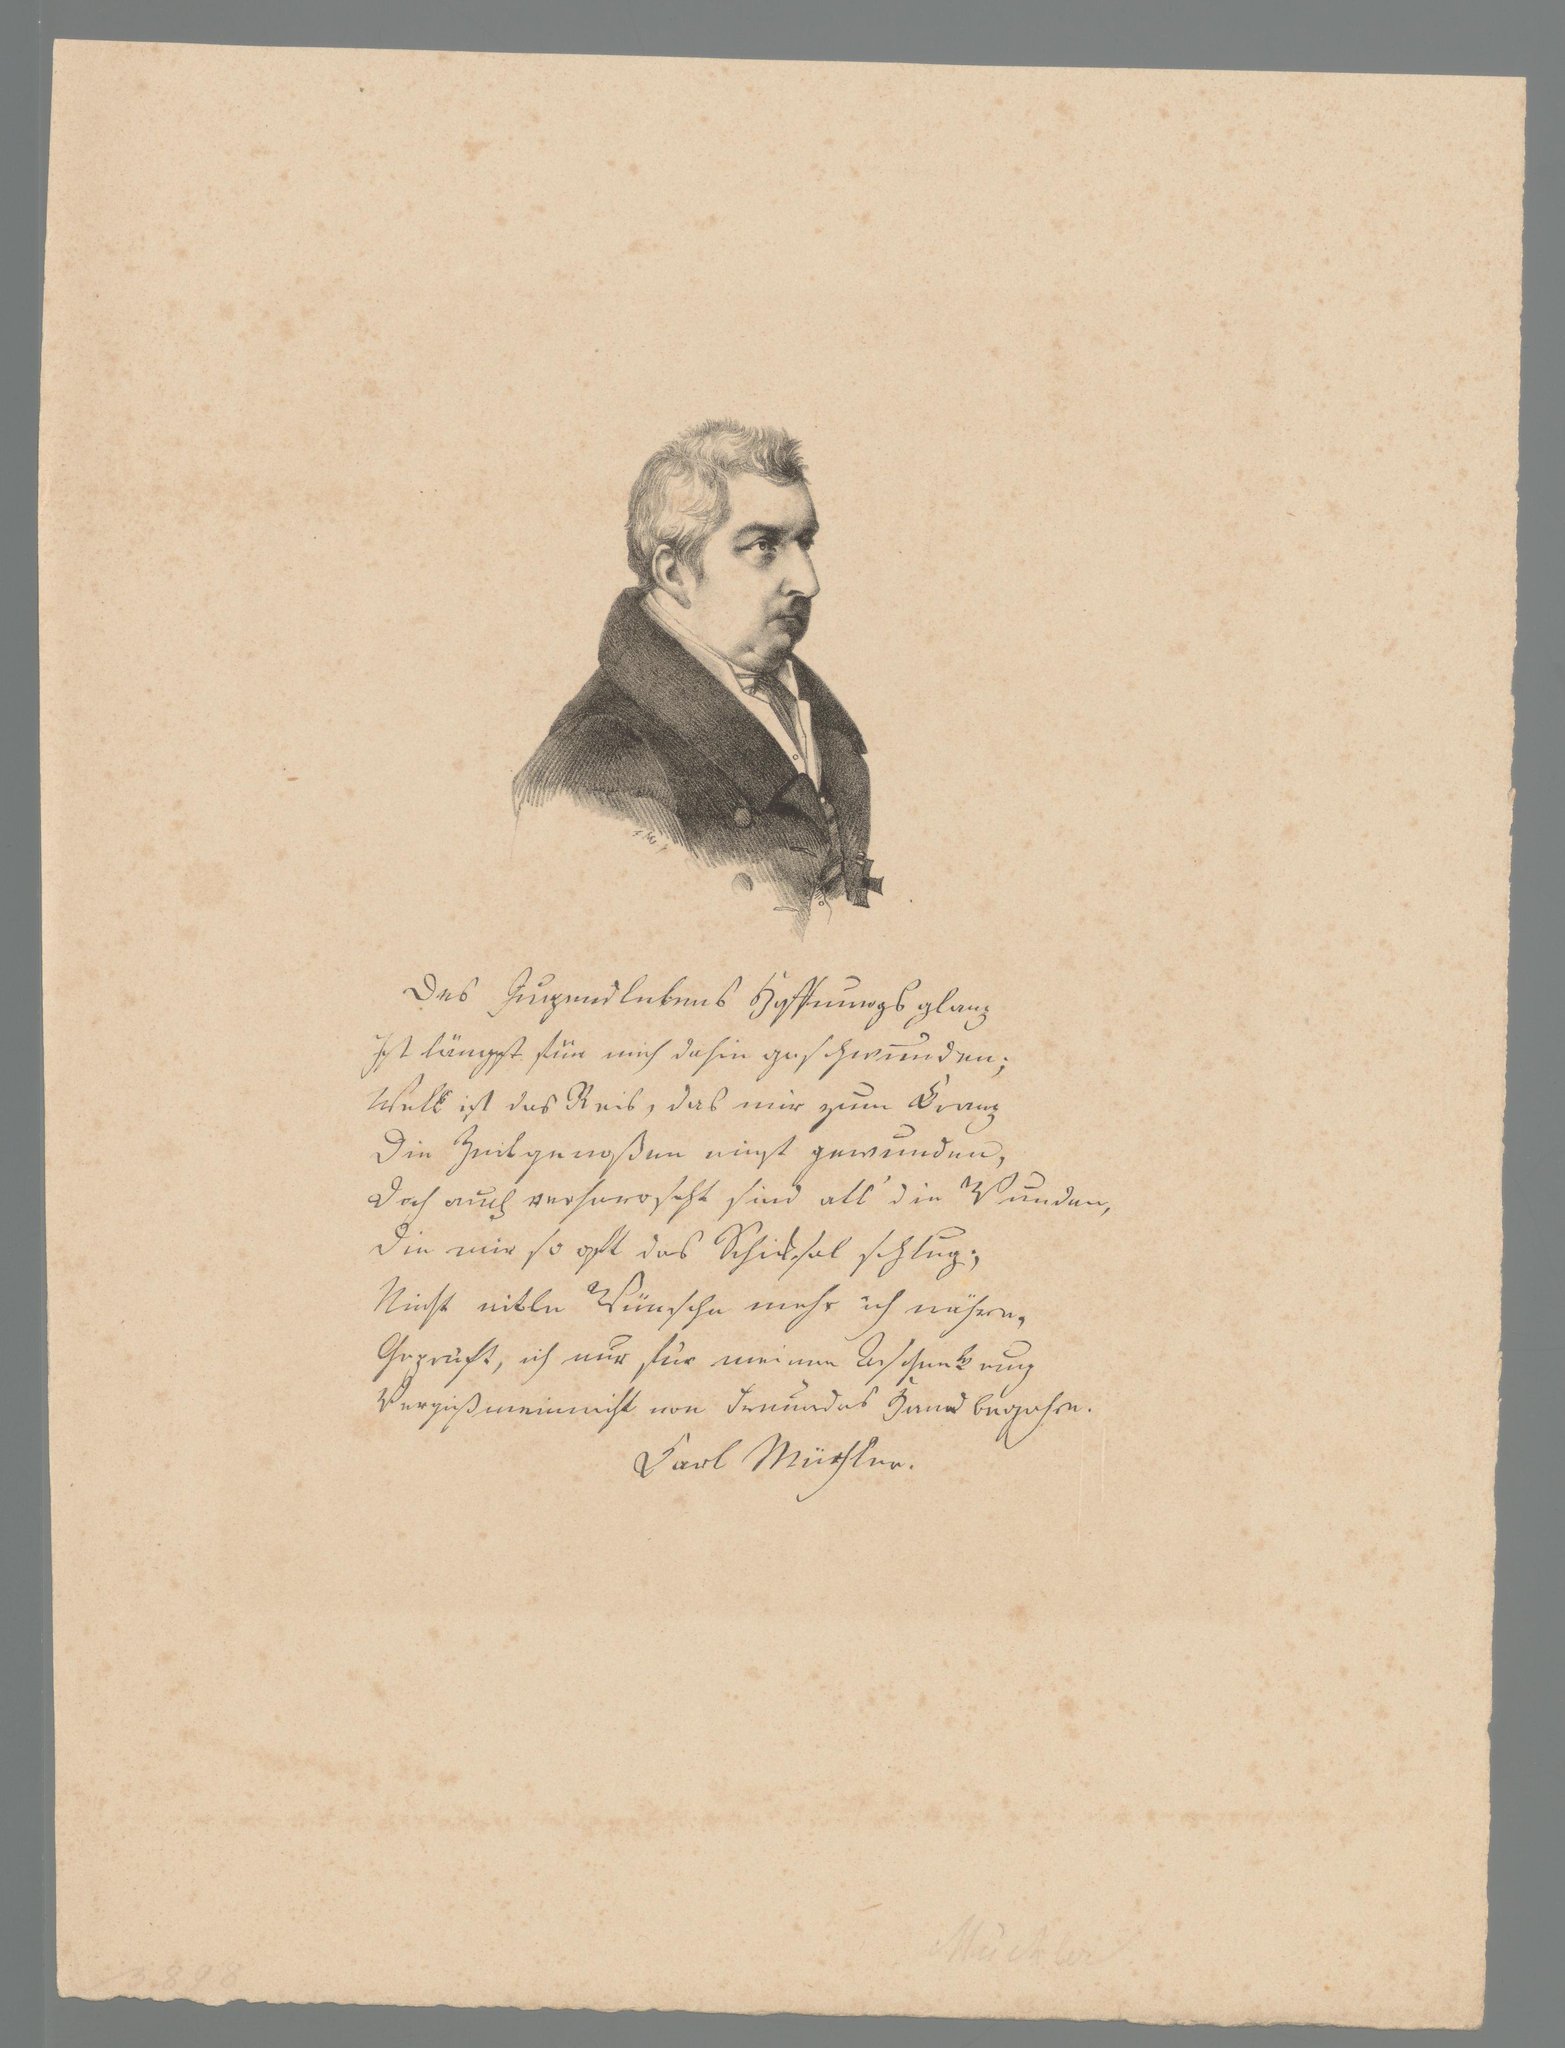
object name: print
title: Portret van Karl Müchler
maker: monogrammist fm (duitsland)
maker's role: print maker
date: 1820-1860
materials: paper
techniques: lithograph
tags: adult man, historical persons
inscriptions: collector's mark: Lugt 2228